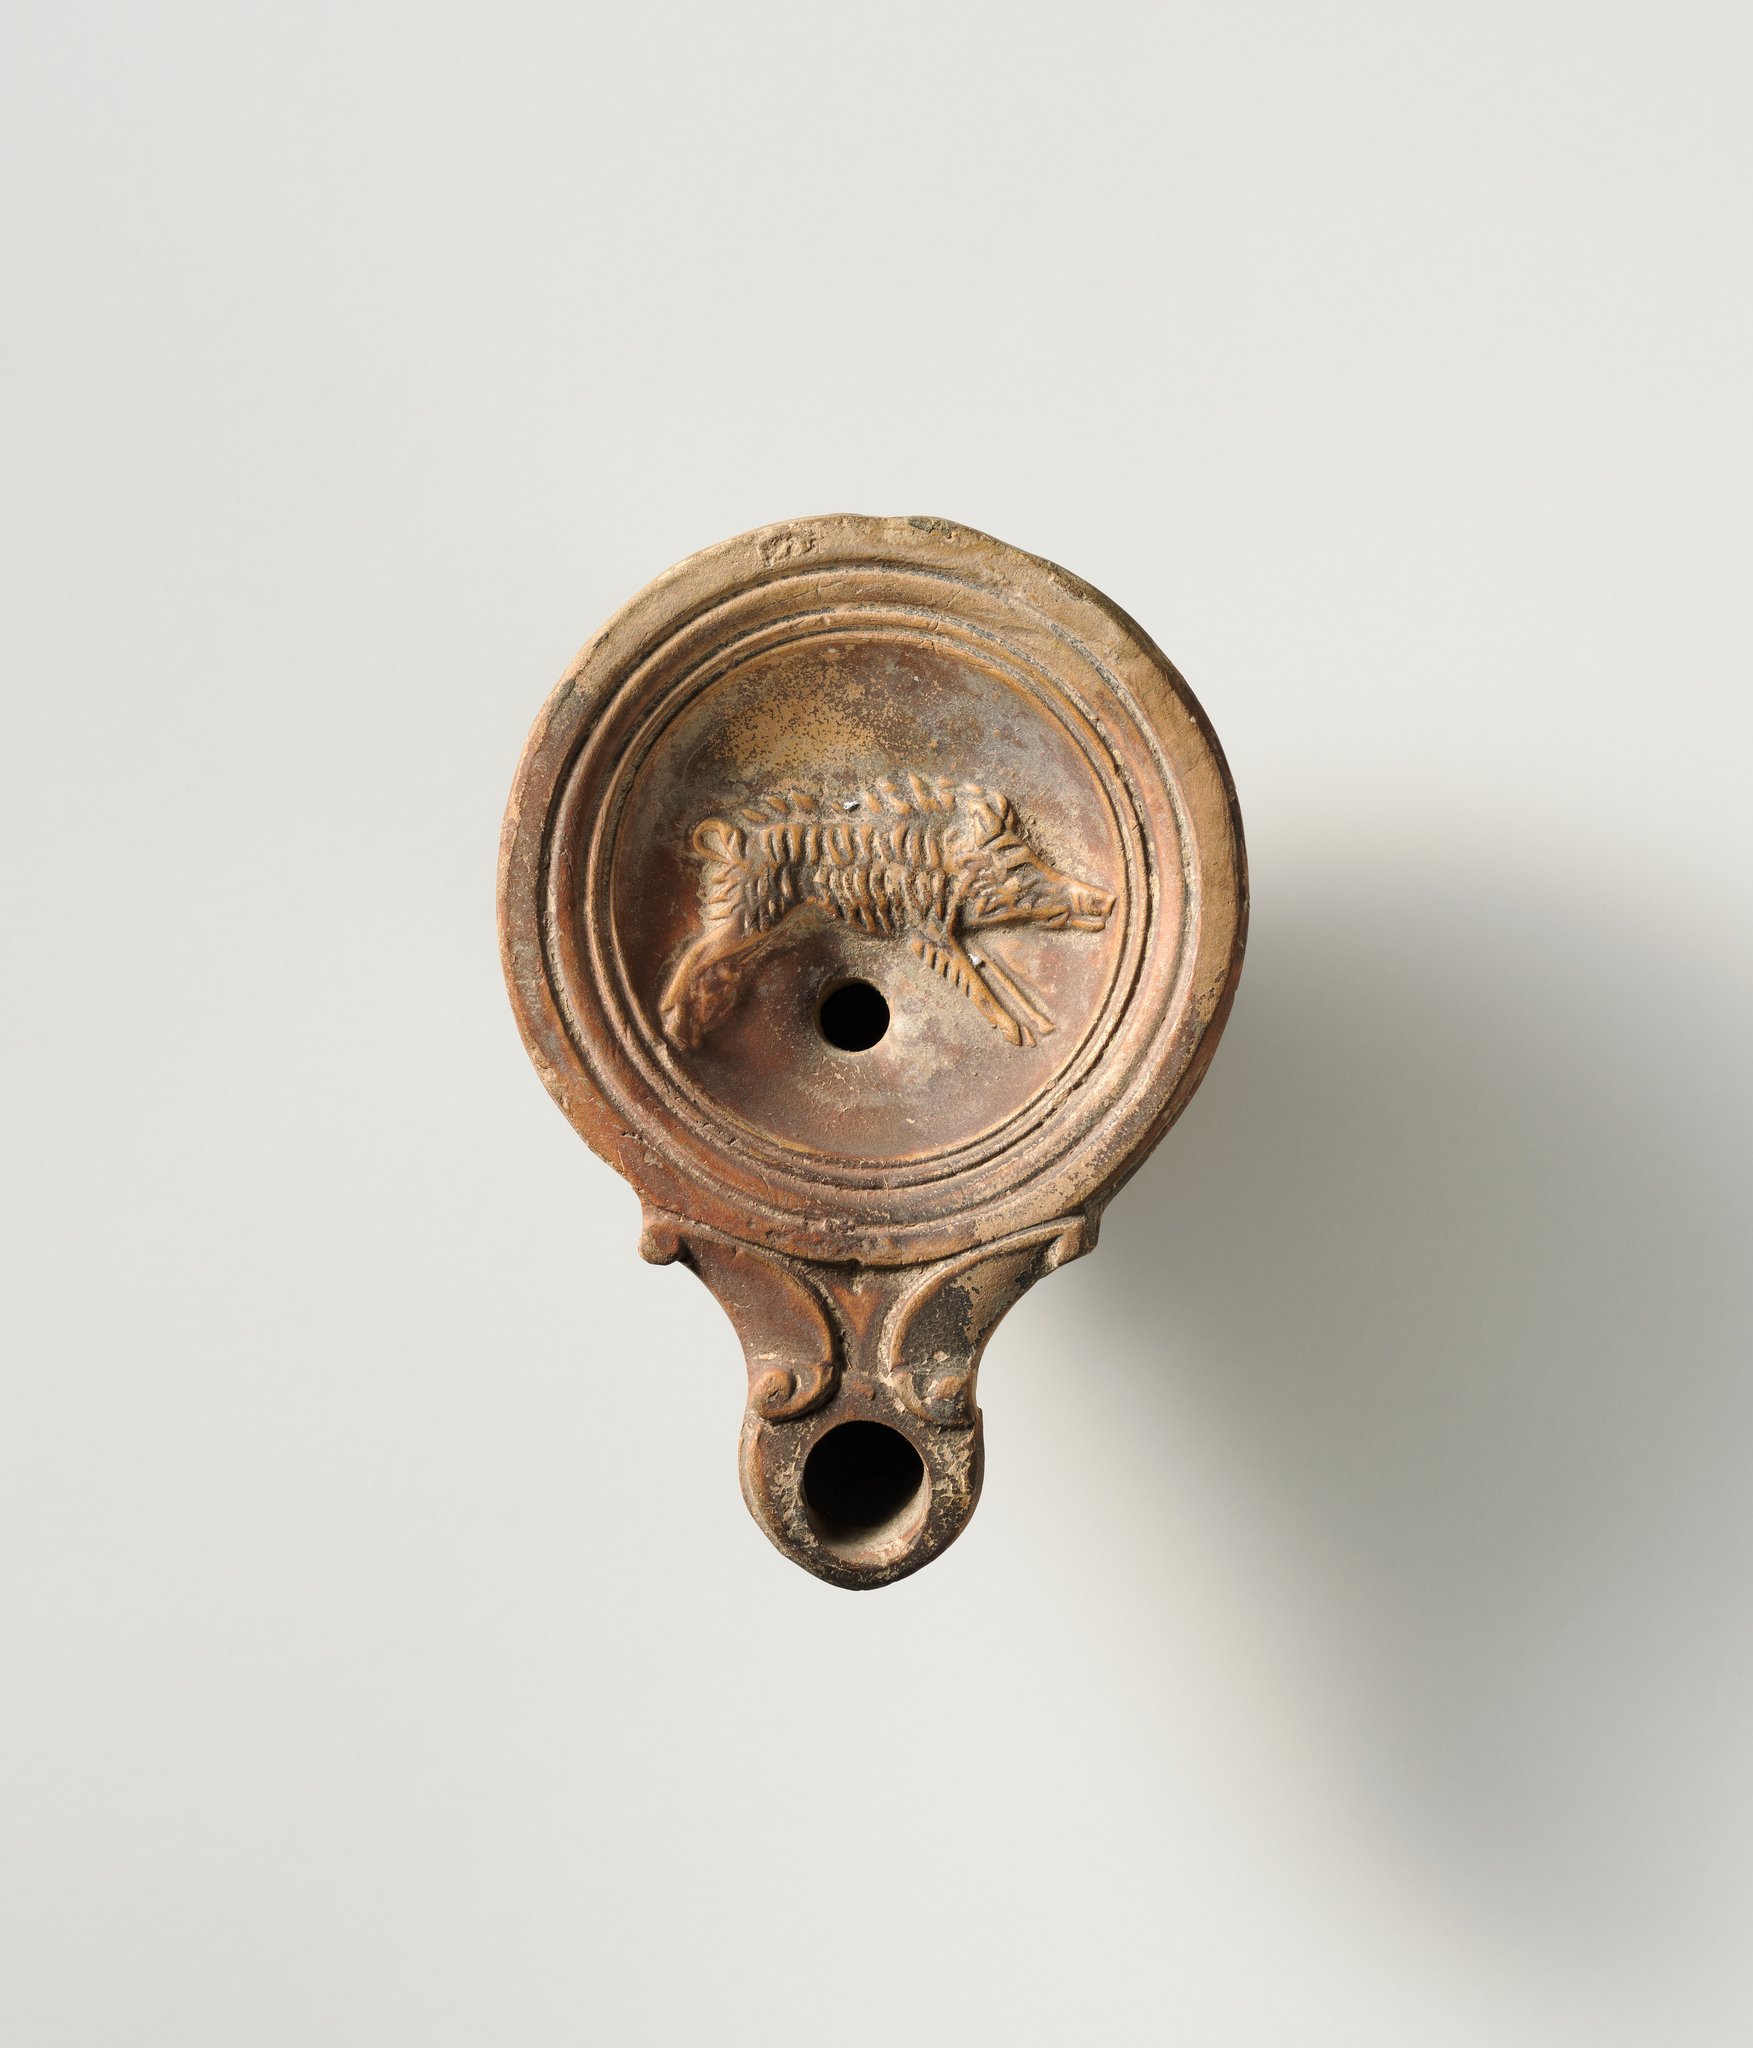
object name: lamp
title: Terracotta oil lamp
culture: roman, cypriot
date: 40-100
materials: terracotta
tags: boars